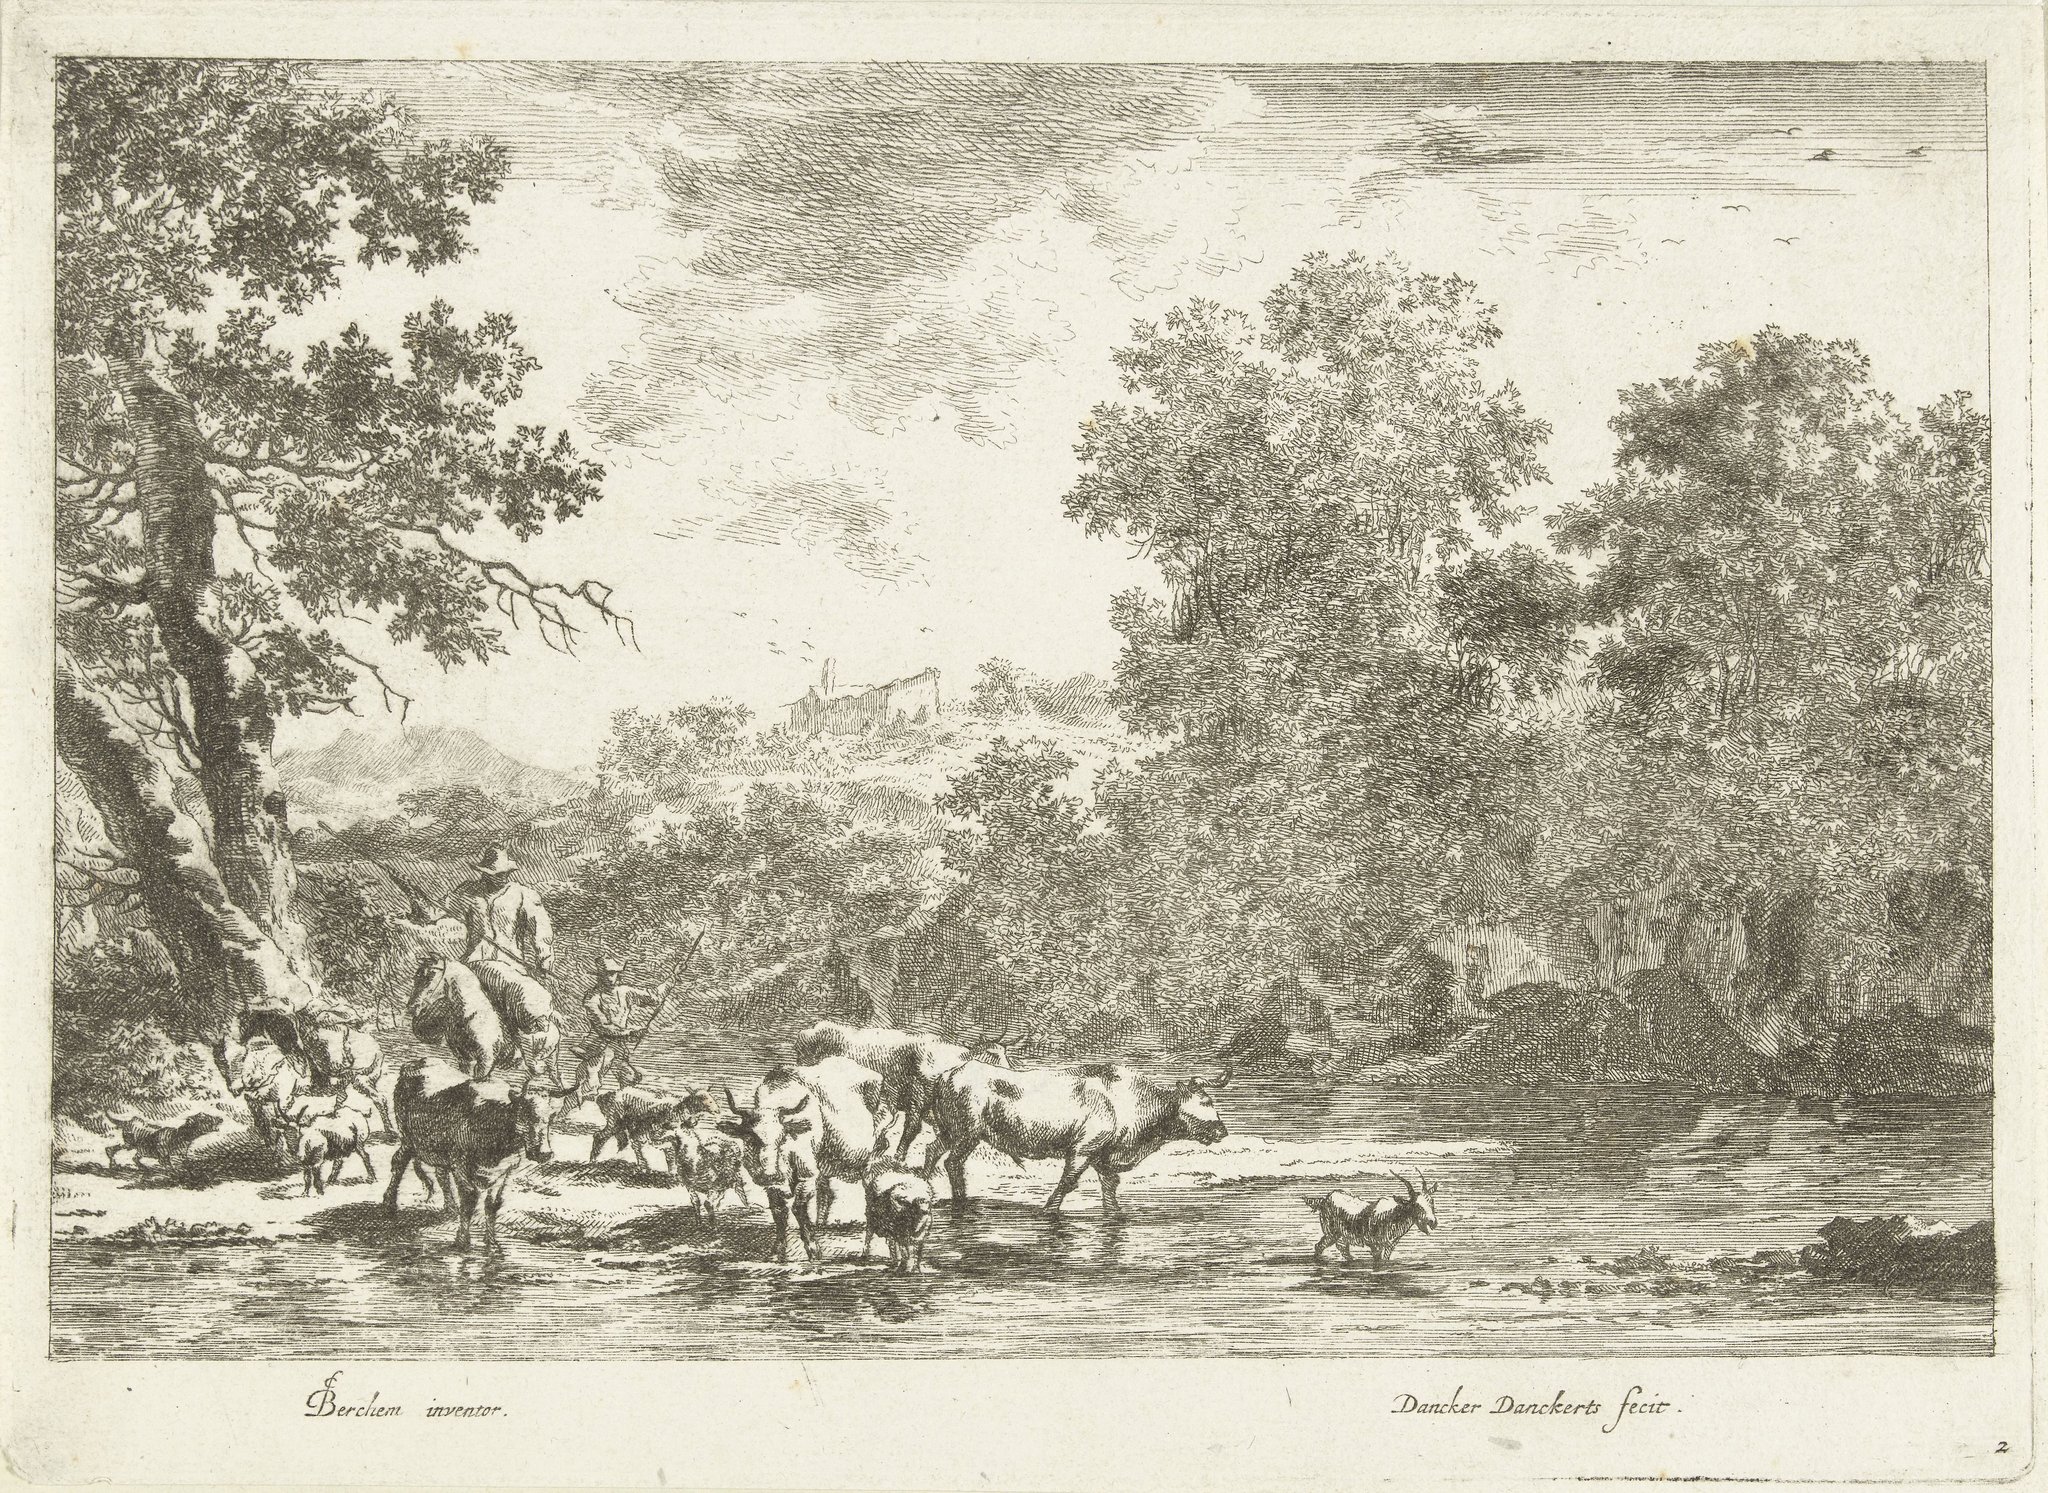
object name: print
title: Italiaans landschap met herder te paard met vee bij rivier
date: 1643-1666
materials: paper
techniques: etching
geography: amsterdam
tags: herding, herdsman, herdswoman, shepherd, shepherdess, cowherd, etc., rocks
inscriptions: collector's mark: Lugt 2228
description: Prent naar ontwerp van Nicolaes Pietersz. Berchem.